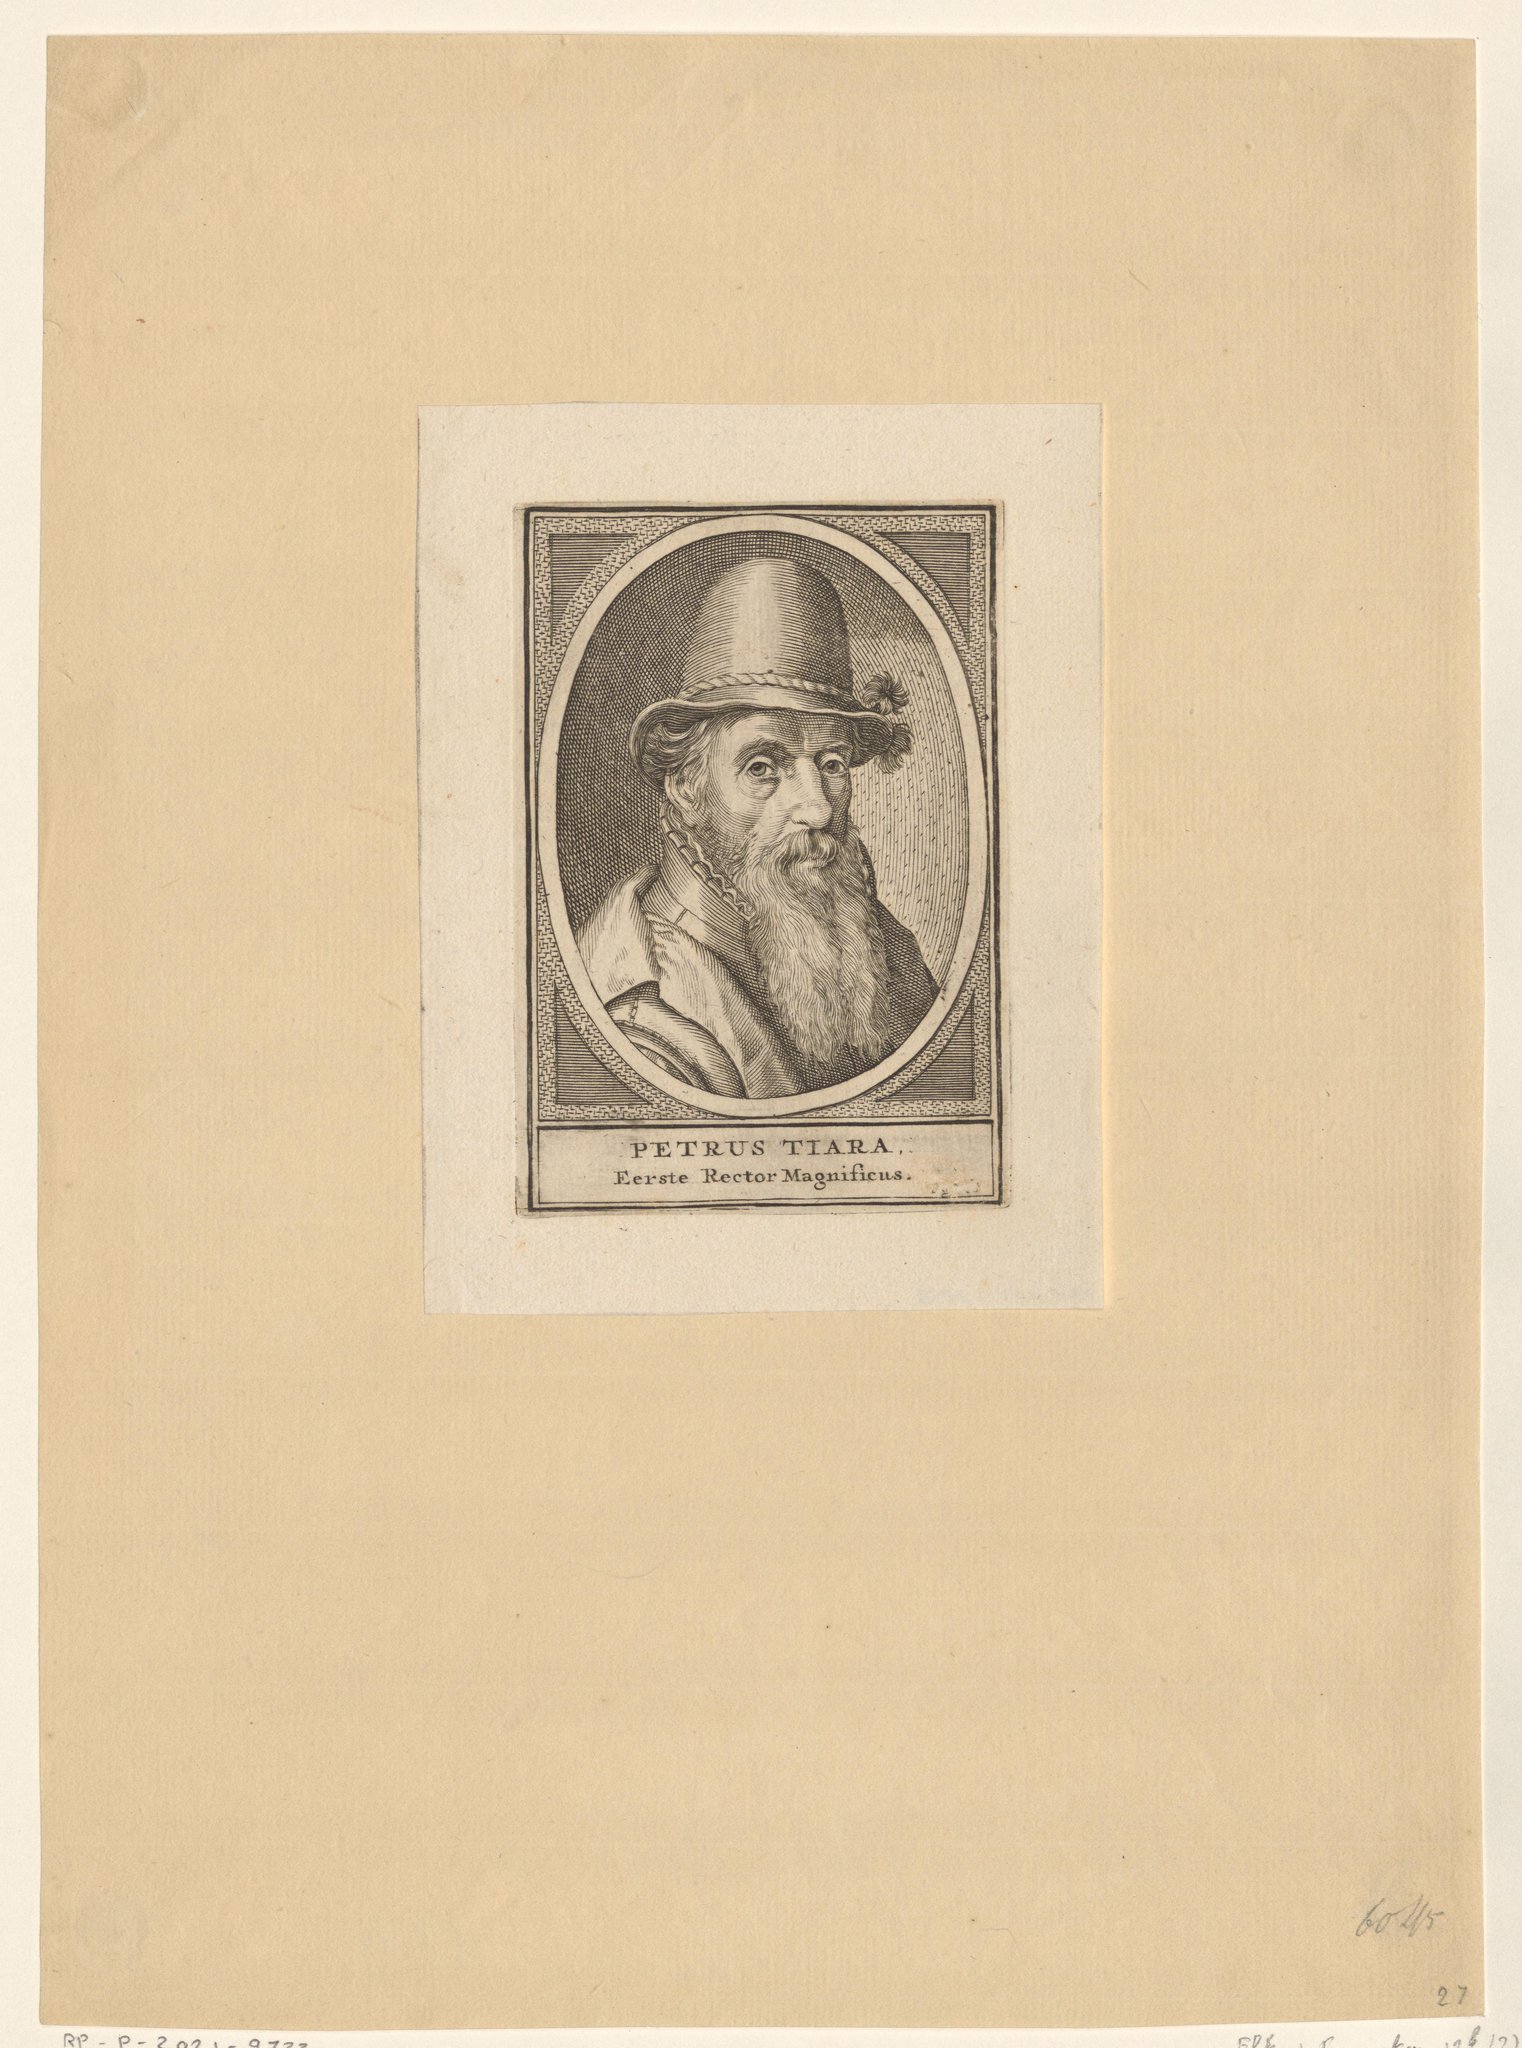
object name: book illustration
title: Portret van Peter Tiara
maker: Anonymous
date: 1614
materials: paper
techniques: engraving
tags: historical persons, professor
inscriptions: collector's mark: Lugt 2228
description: Eerste staat van de prent gebruikt in: Illustrium Hollandiae & Westfrisiae ordinum alma academia Leidensis. Leiden: Jacob Marcus en Joost van Colster, 1614. Huidige staat van de prent, maar met paginanummer rechtsonder (hier verwijderd) gebruikt in: Fabricius, Franciscus. Redenvoering over den hondert en vyftigsten verjaardag, of het derde jubeljaar der Hollandsche akademie te Leiden. Leiden: Pieter van der Aa, 1725.